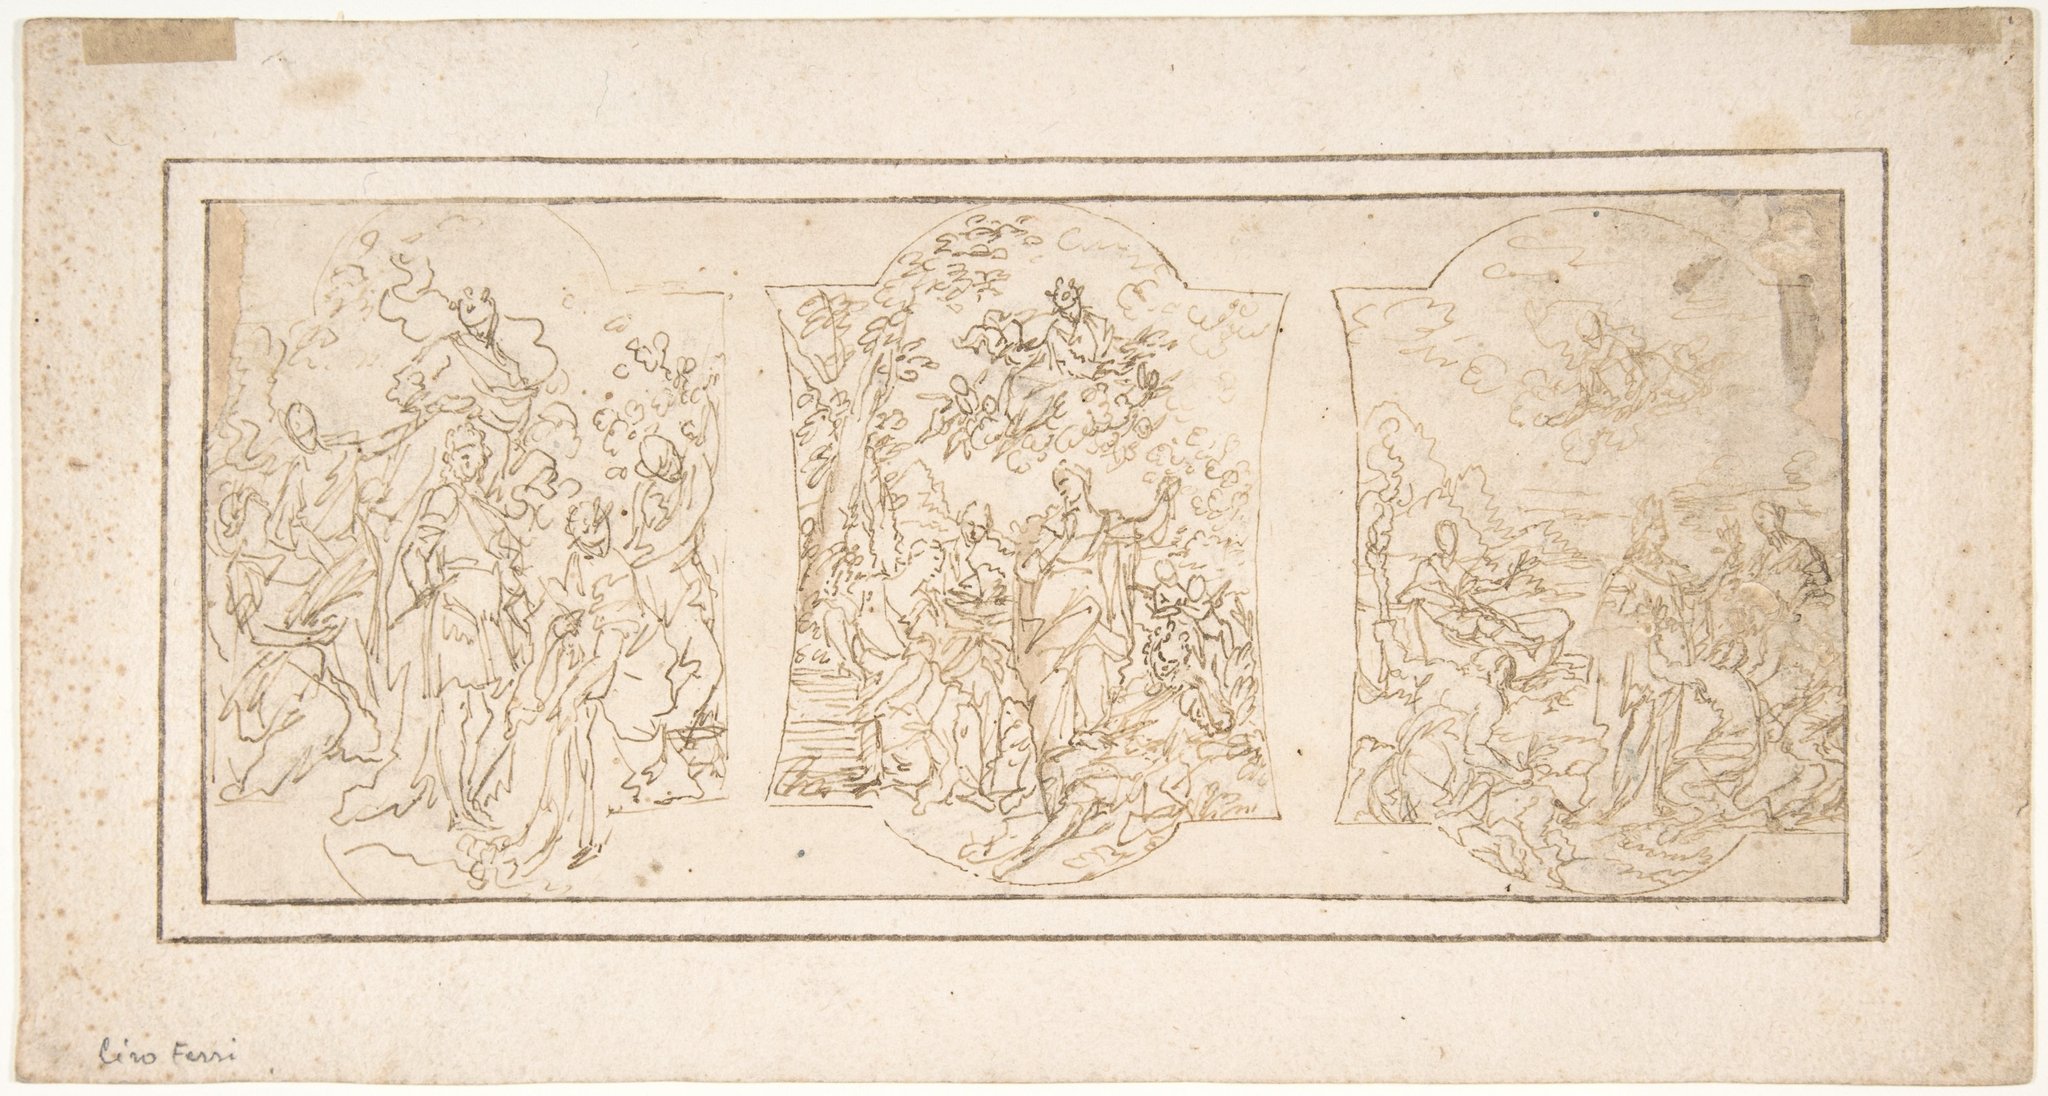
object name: drawing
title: Drawing for Ceiling Decoration Consisting of Three Panels Each Showing a Different Scene with Figures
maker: ciro ferri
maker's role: artist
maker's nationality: italian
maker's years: 1634-1689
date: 1634-1689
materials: ink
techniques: pen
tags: human figures